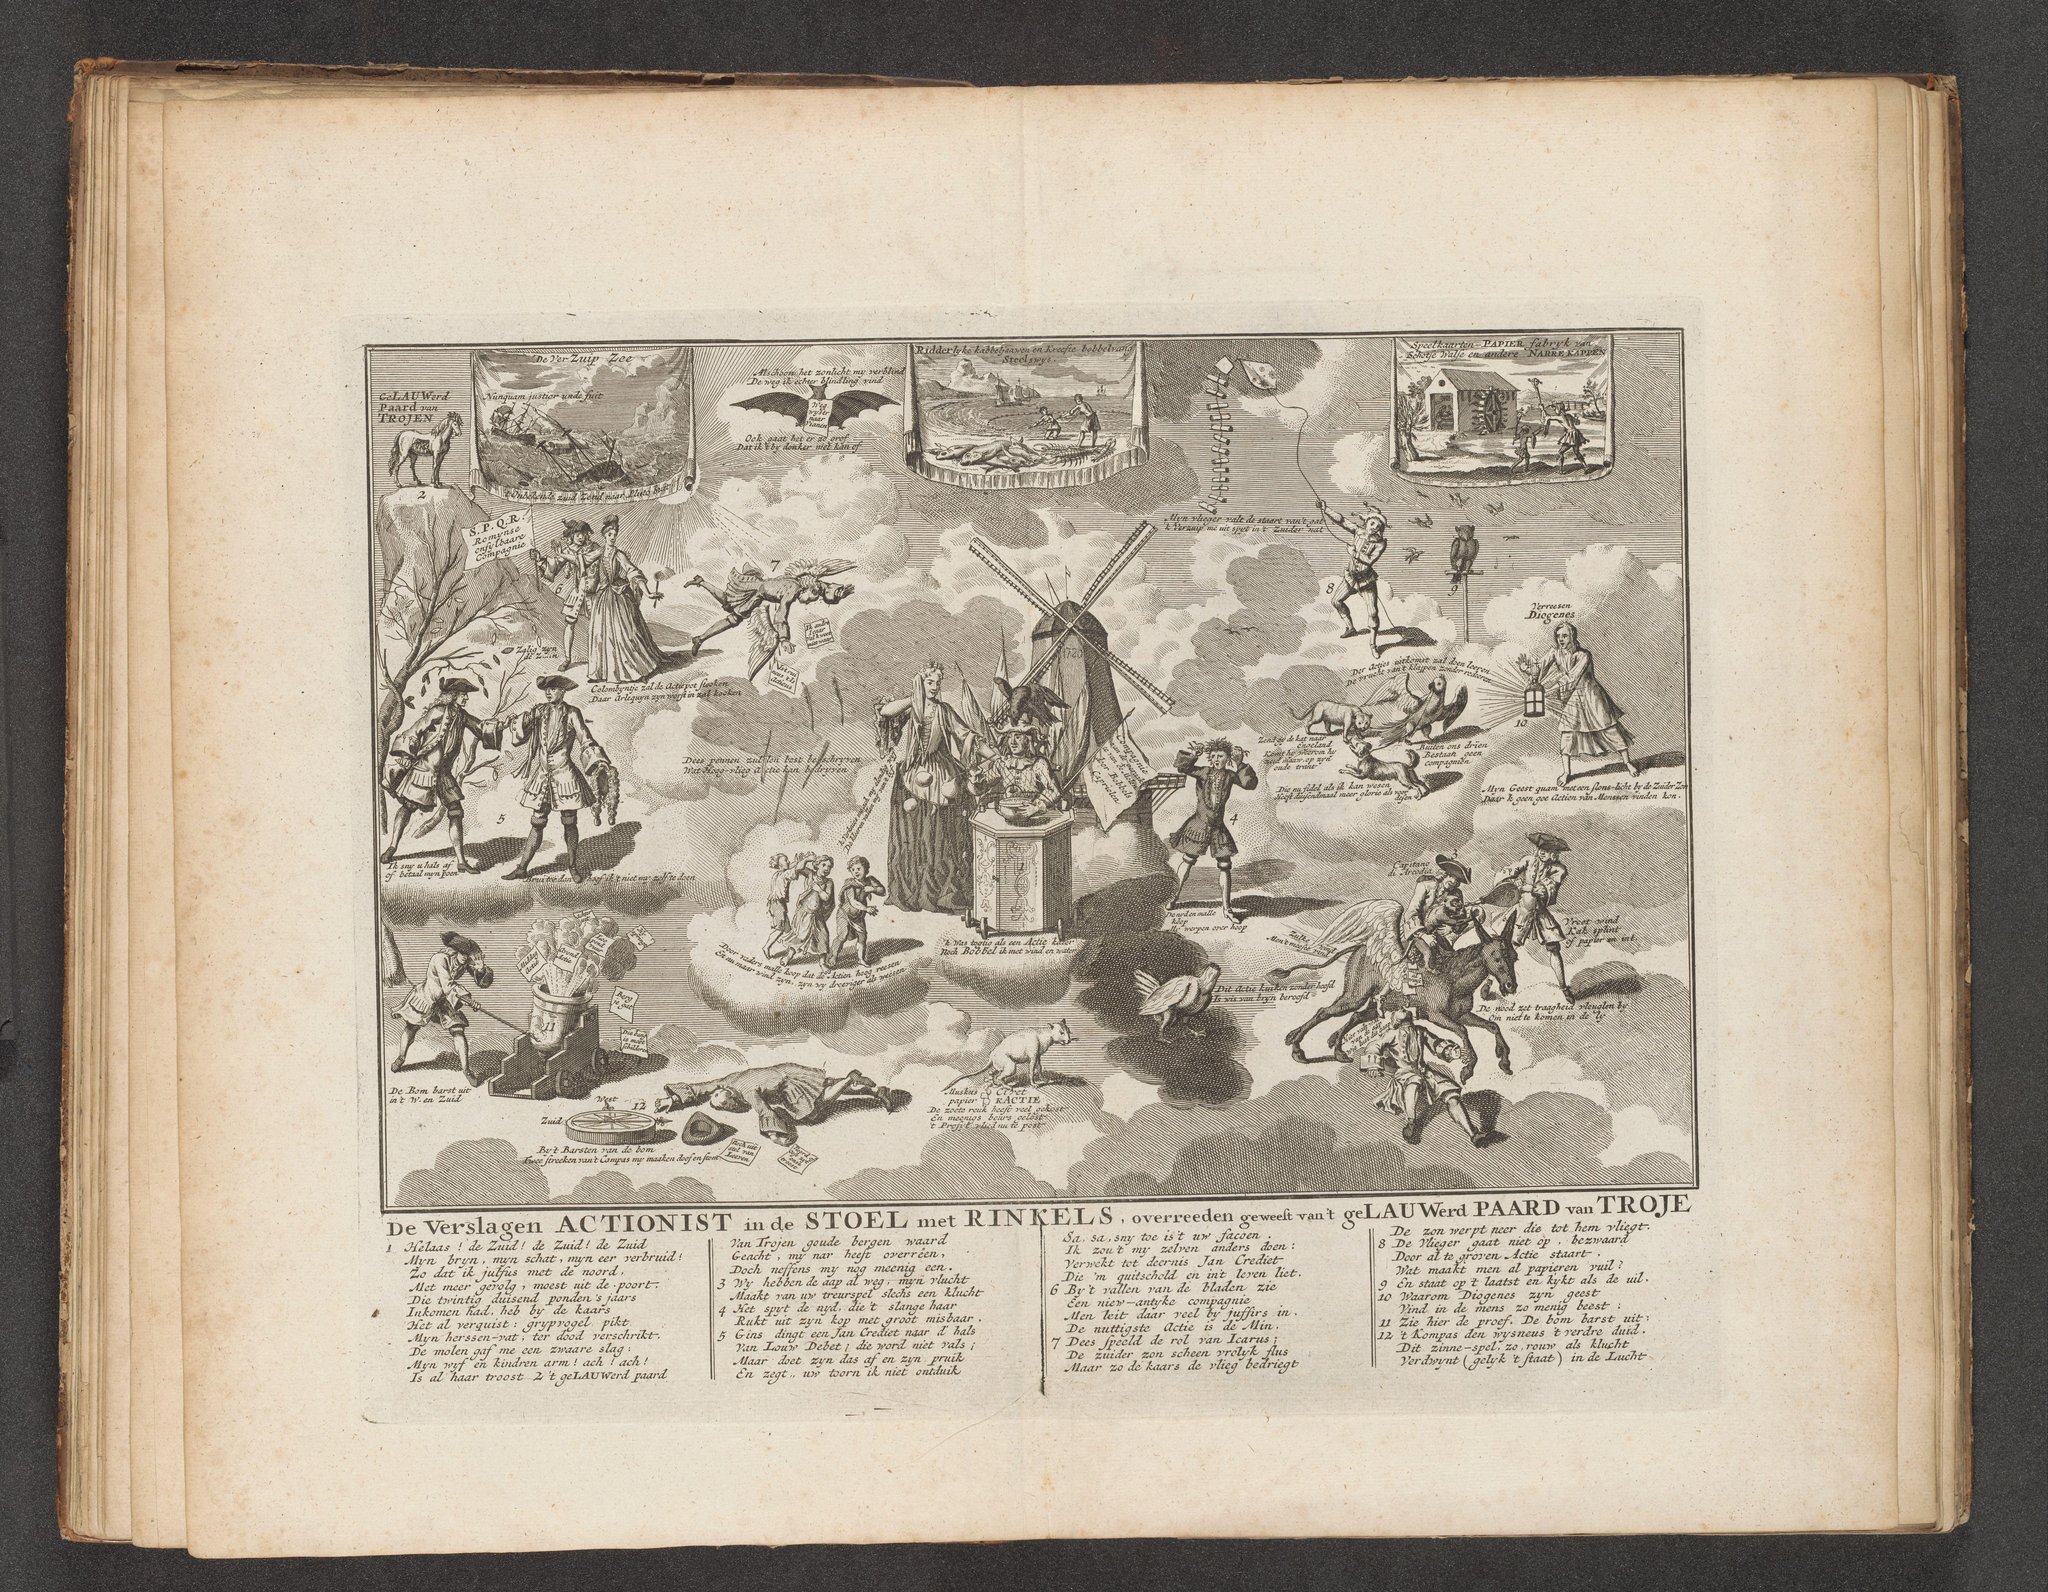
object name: print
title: De Verslagen Actionist in de Stoel met Rinkels, overreeden geweest van 't geLauwerd Paard van Troje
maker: Anonymous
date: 1720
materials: paper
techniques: etching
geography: northern netherlands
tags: court jester, court fool, baby-chair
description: In de wolken zit centraal de verslagen actionist in een narrenpak in de rinkelstoel (kinderstoel op wieltjes), daarachter een windmolen met het jaartal 1720. Hieromheen verschillende andere zinnebeeldige scènes. Linksboven het gelauwerd paard van Troje, een verwijzing naar John Law. Op de voorgrond een civetkat. In het onderschrift de verklaring van de cijfers 1-12 in de voorstelling. Prent in de gebonden vierde uitgave (304 B 12) van Het Groote Tafereel der Dwaasheid met spotprenten op de Windhandel of Actiehandel van 1720.